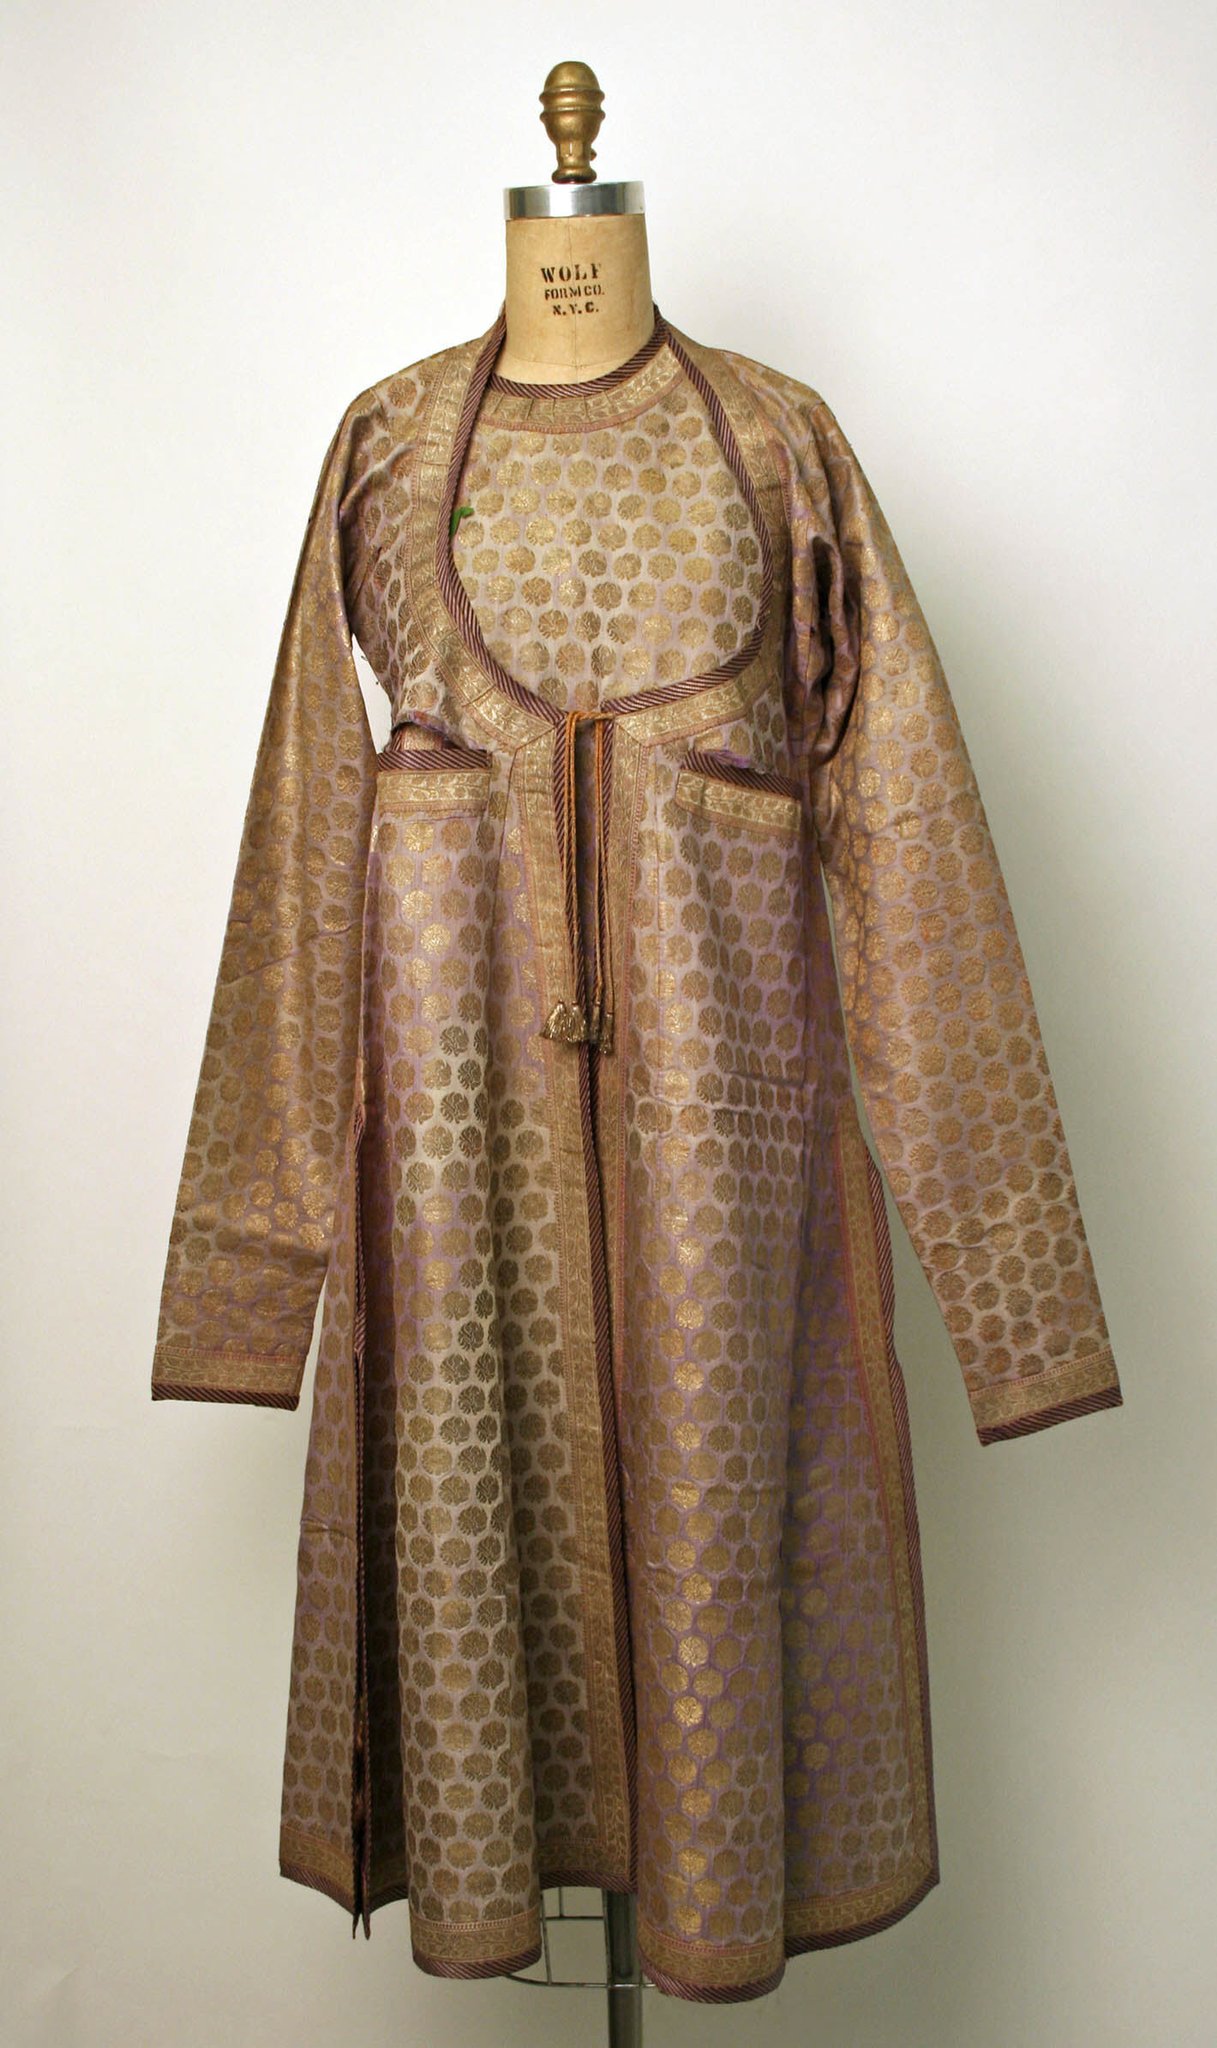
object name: coat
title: Angarkha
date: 1801-1900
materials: metal thread, silk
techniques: weave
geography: india